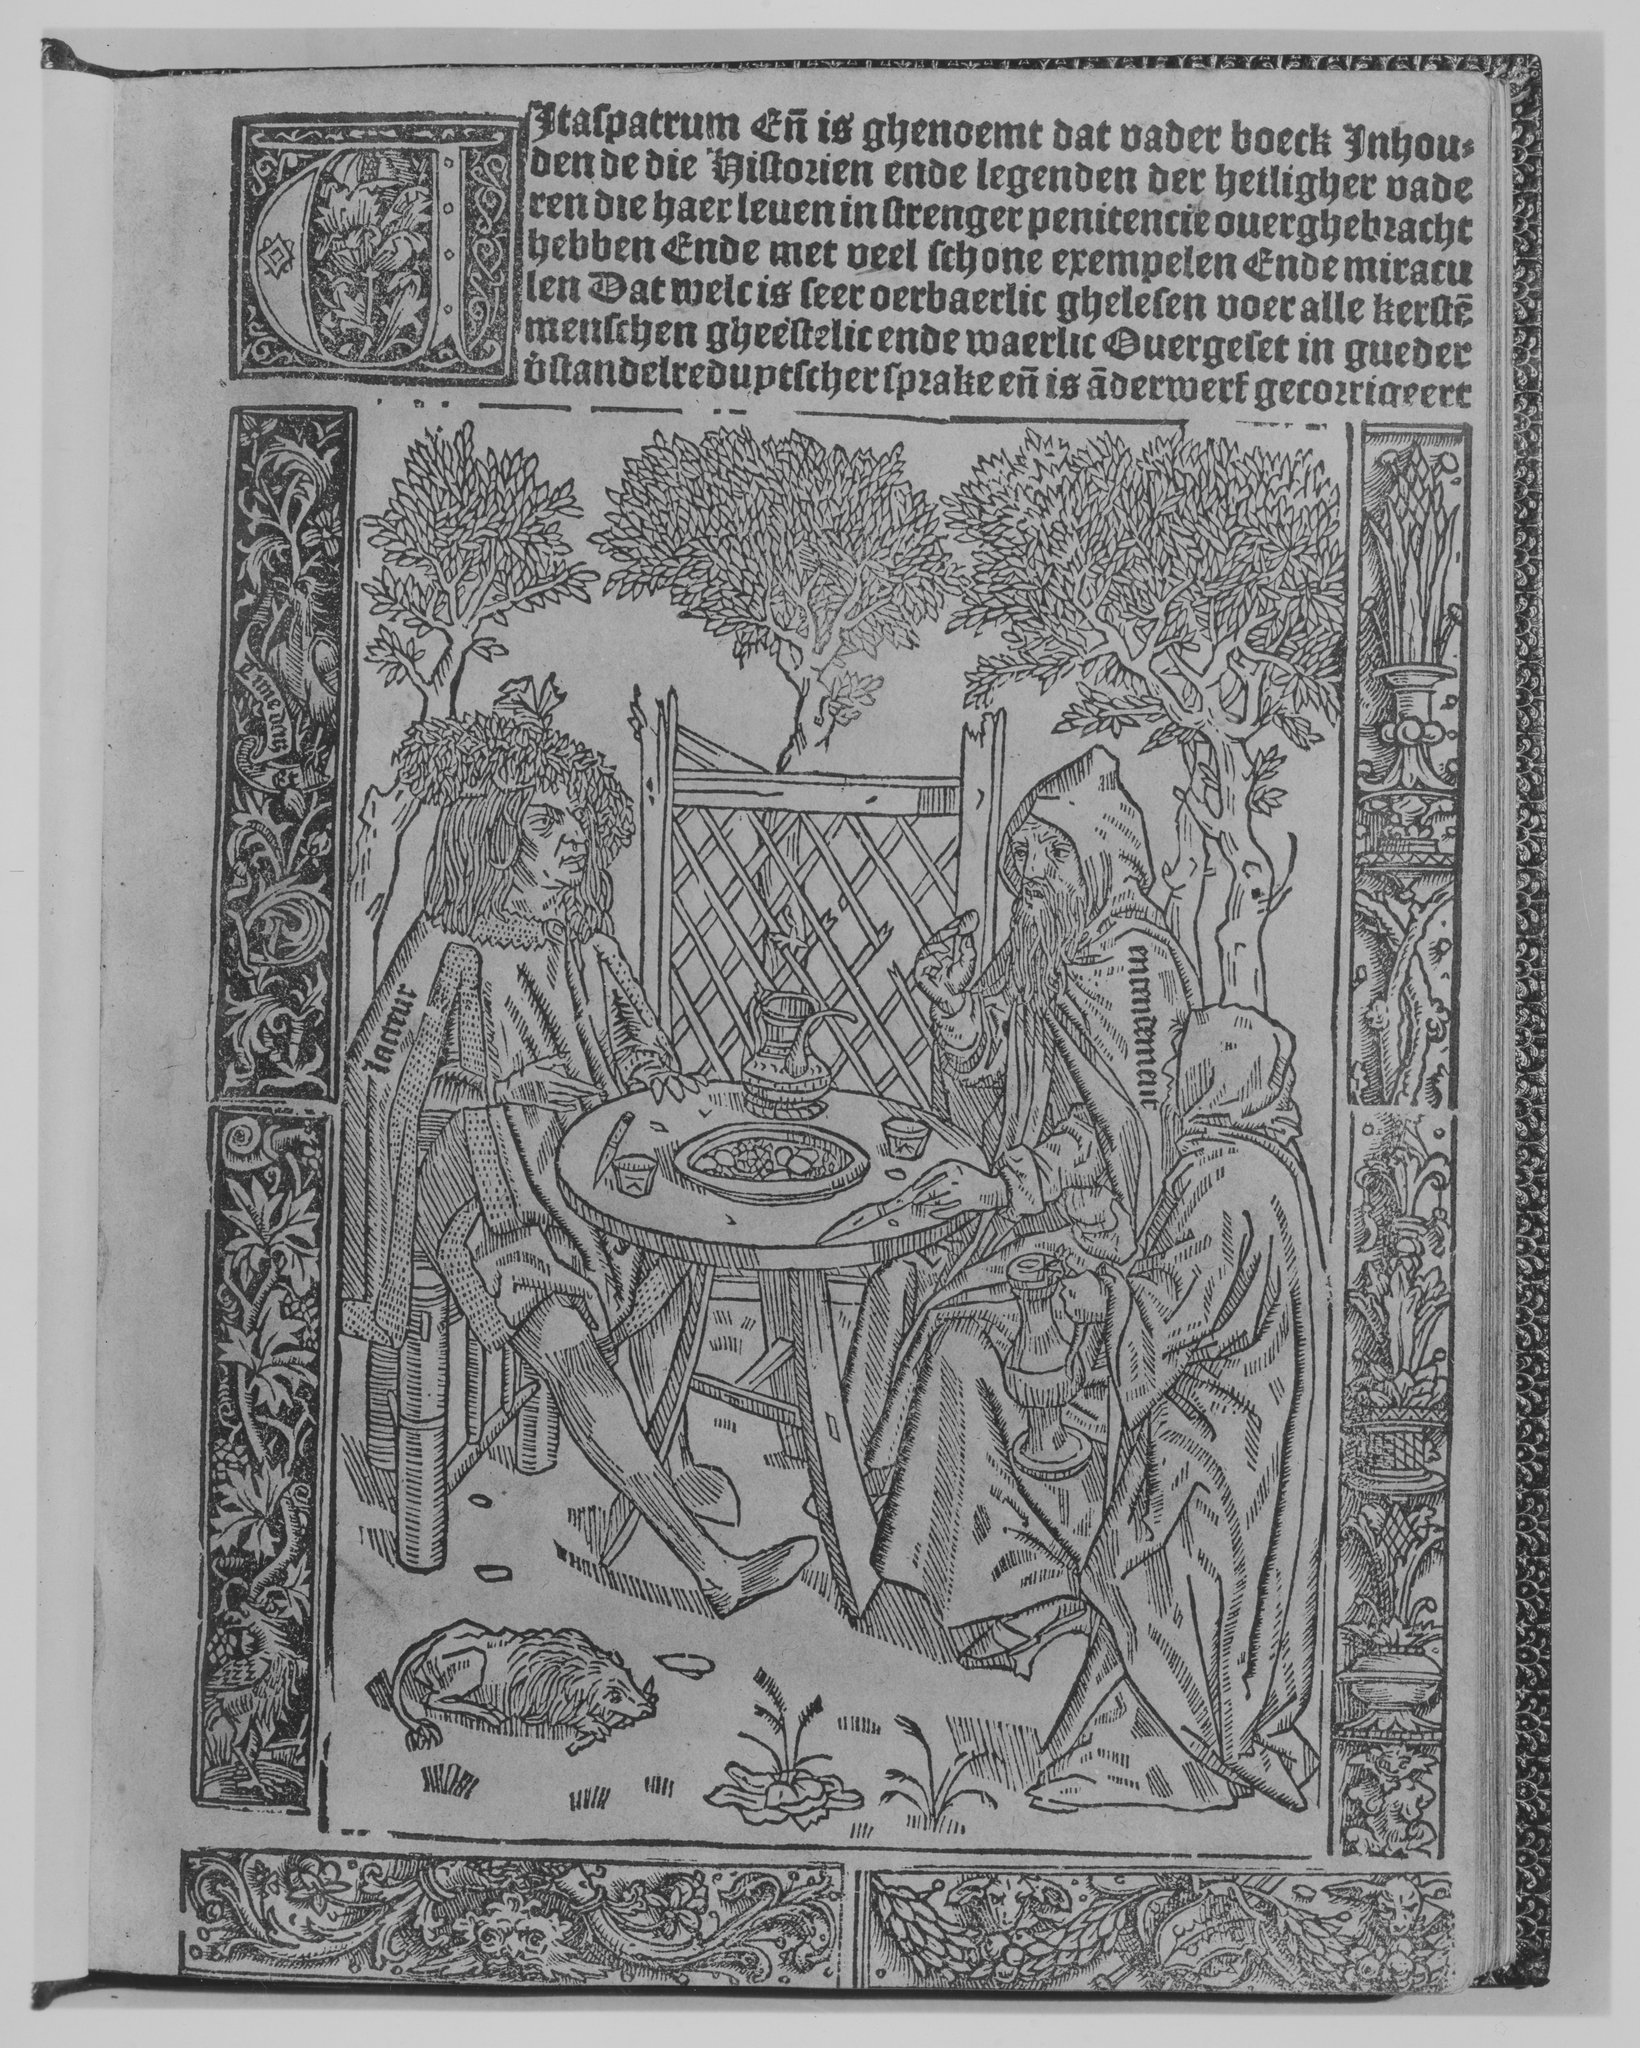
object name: book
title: Vitae Patrum (Lives of the Desert Fathers)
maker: saint jerome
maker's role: author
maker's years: 347-420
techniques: woodcut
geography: leiden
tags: men,women,trees,tables